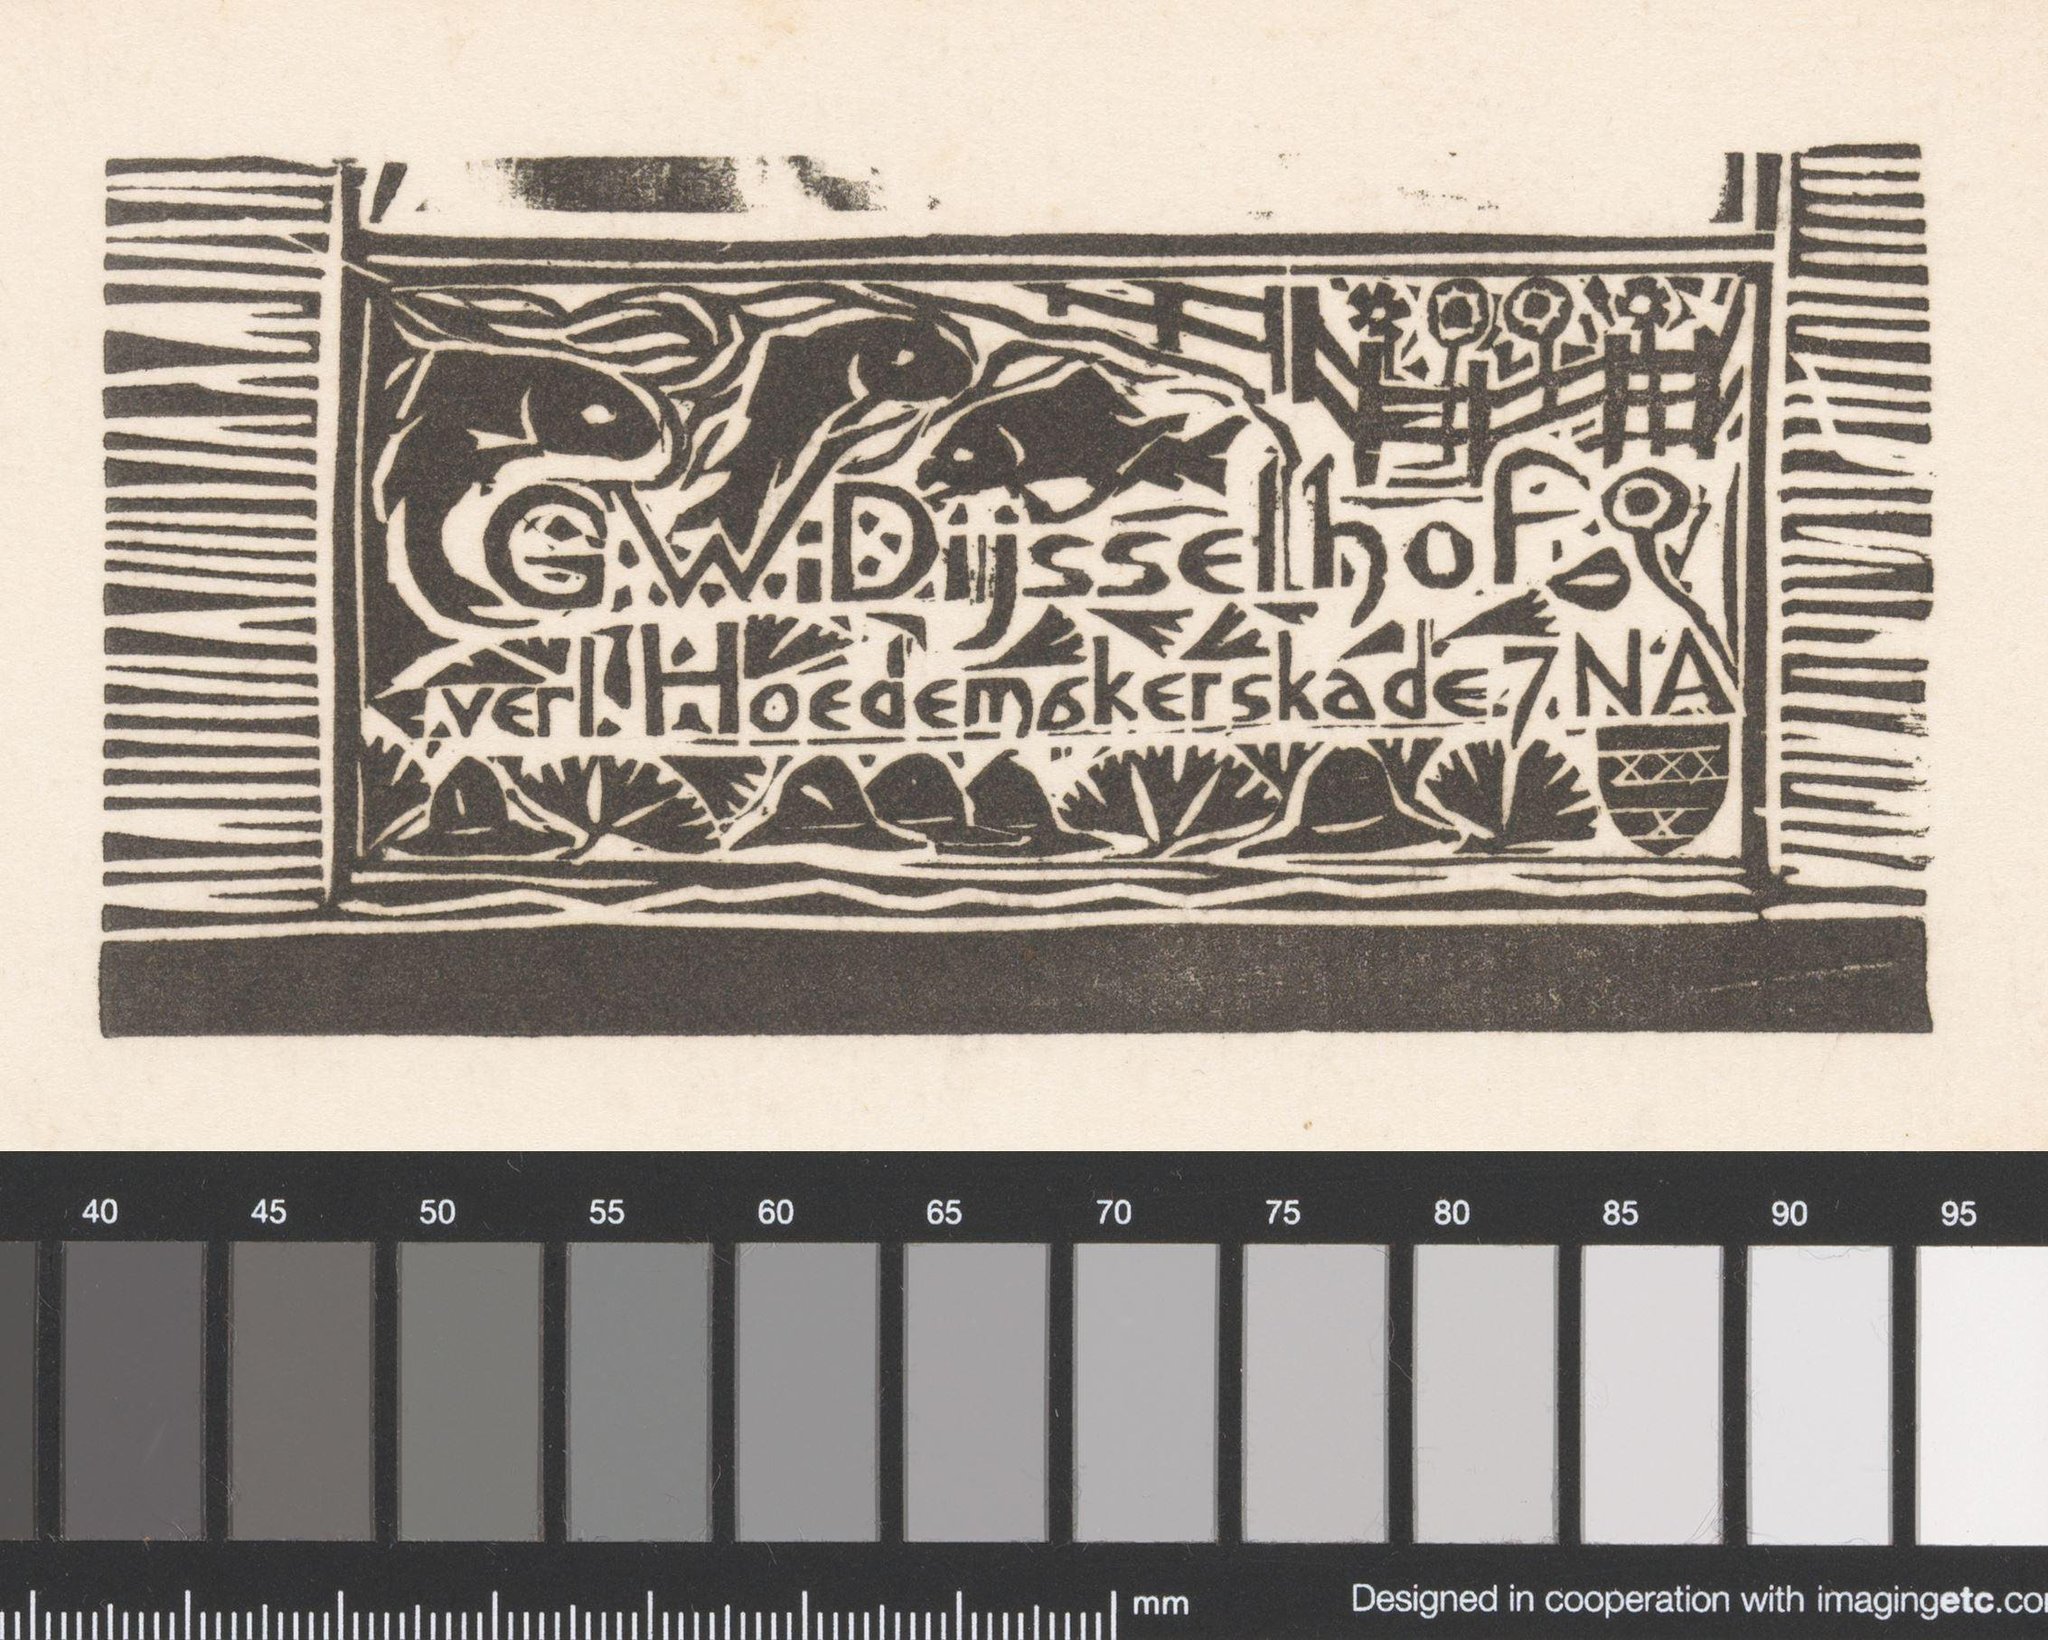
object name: print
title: Visitekaartje van Gerrit Willem Dijsselhof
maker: gerrit willem dijsselhof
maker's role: designer, draughtsman, print maker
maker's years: 1866-1924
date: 1892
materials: paper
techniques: woodcut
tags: print maker, draughtsman, gerrit willem dijsselhof, visiting-card, calling-card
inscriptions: collector's mark: Lugt 2228, collector's mark: Lugt 2760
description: Een visitekaartje met bloemen bij een tuinhek, drie vissen, een rij hoeden, het wapen van Nieuwer-Amstel en het adres van Gerrit Willem Dijsselhof: Verlengde Hoedemakerskade 7 te Nieuwer-Amstel, de huidige Sint Willibrordusstraat in Amsterdam.